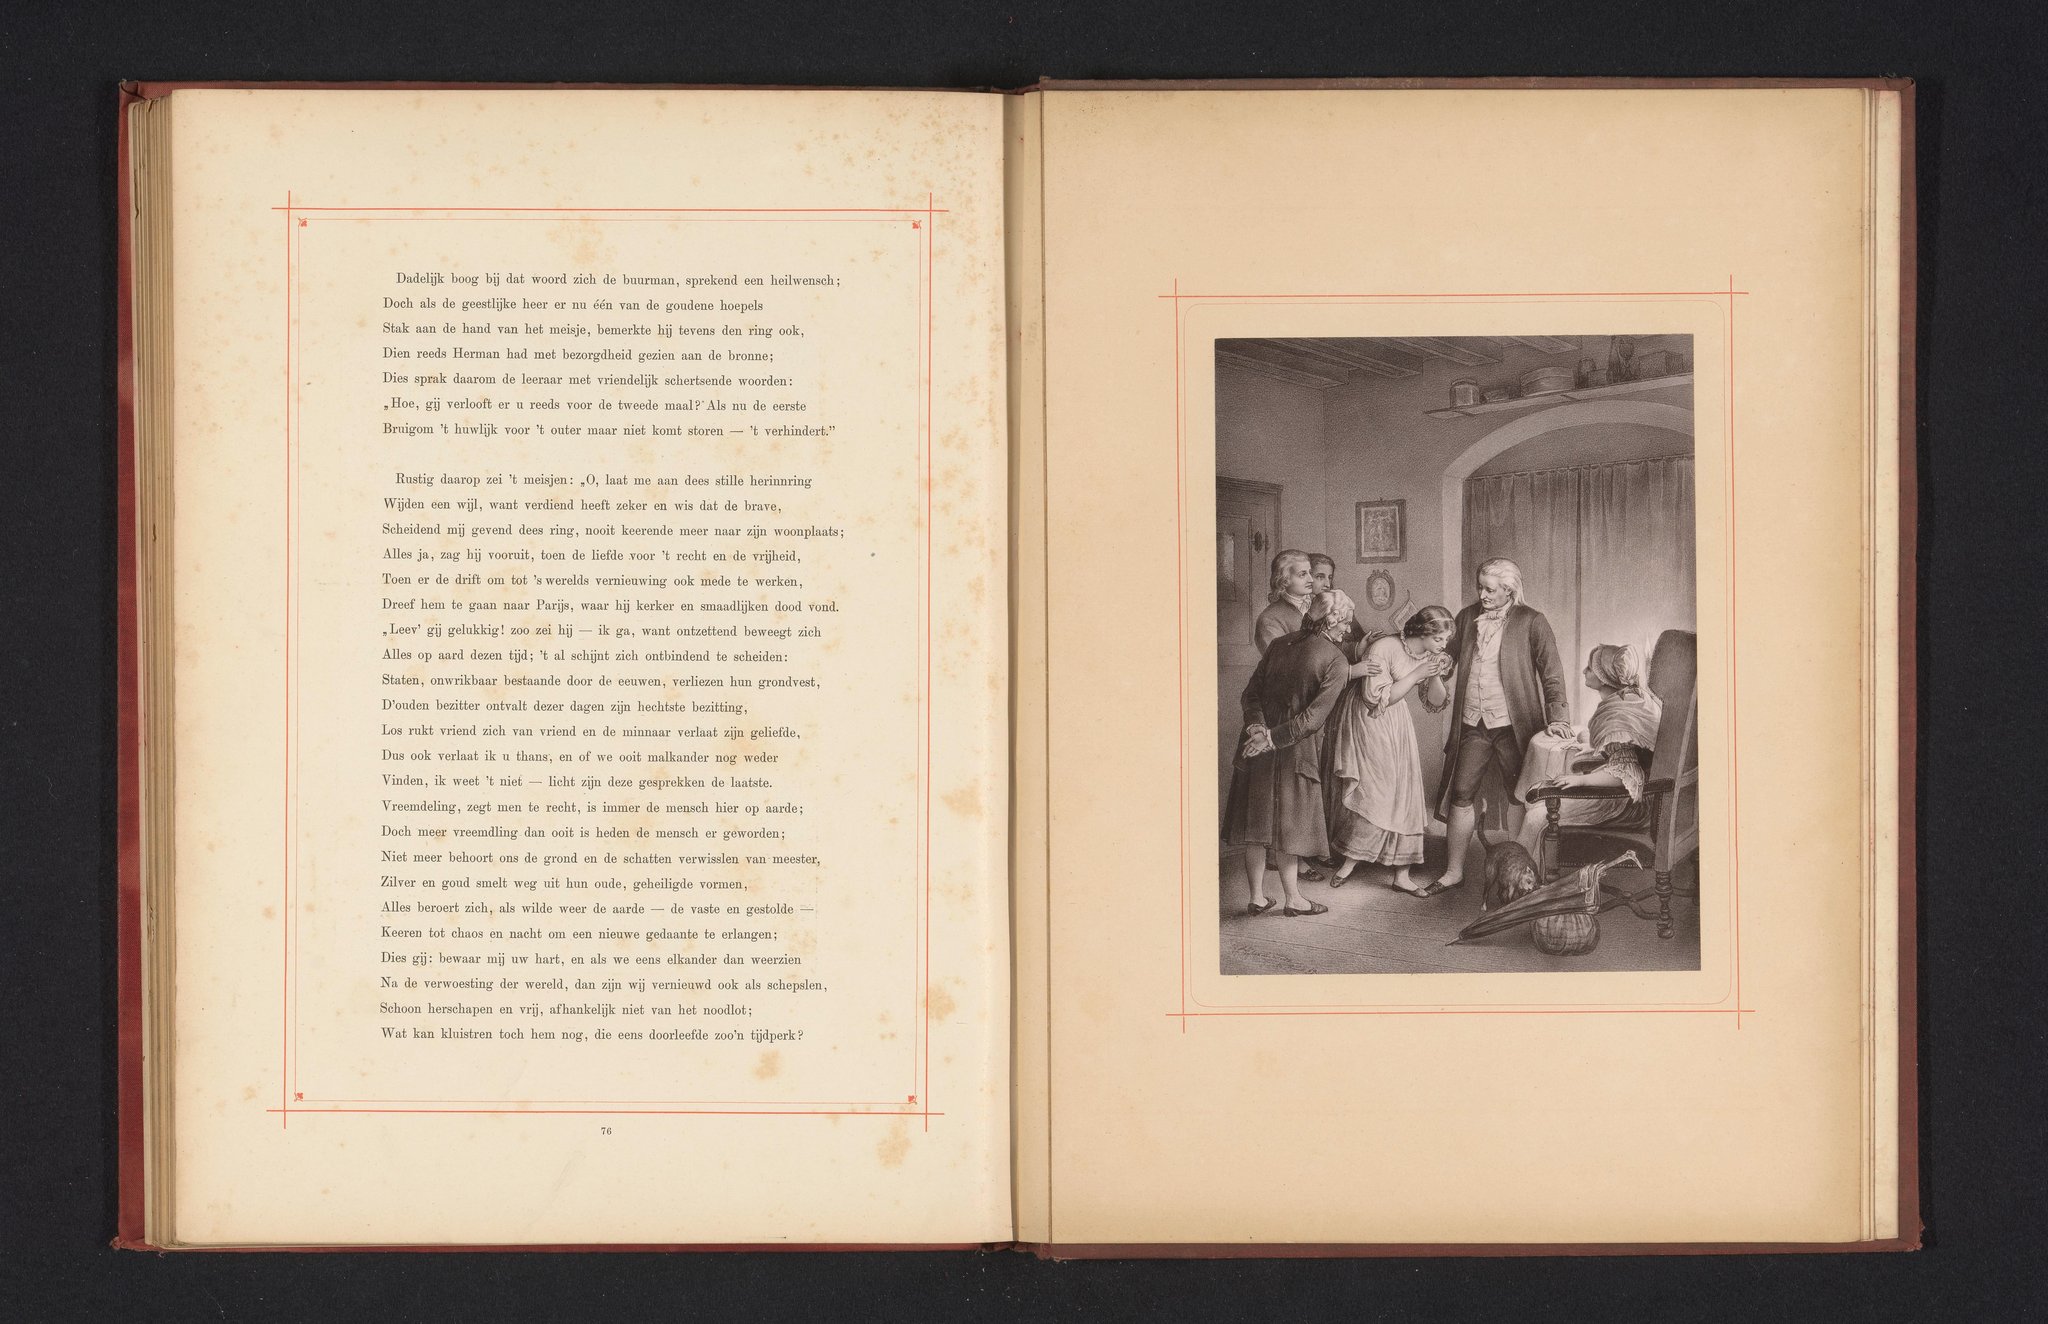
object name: reproduction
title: Fotoreproductie van een tekening, voorstellende Dorothea kust de hand van de vader van Hermann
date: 1875-1885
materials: paper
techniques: photograph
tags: adult woman, adult man, interior ~ representation of a building, parents (first degree family relationships)